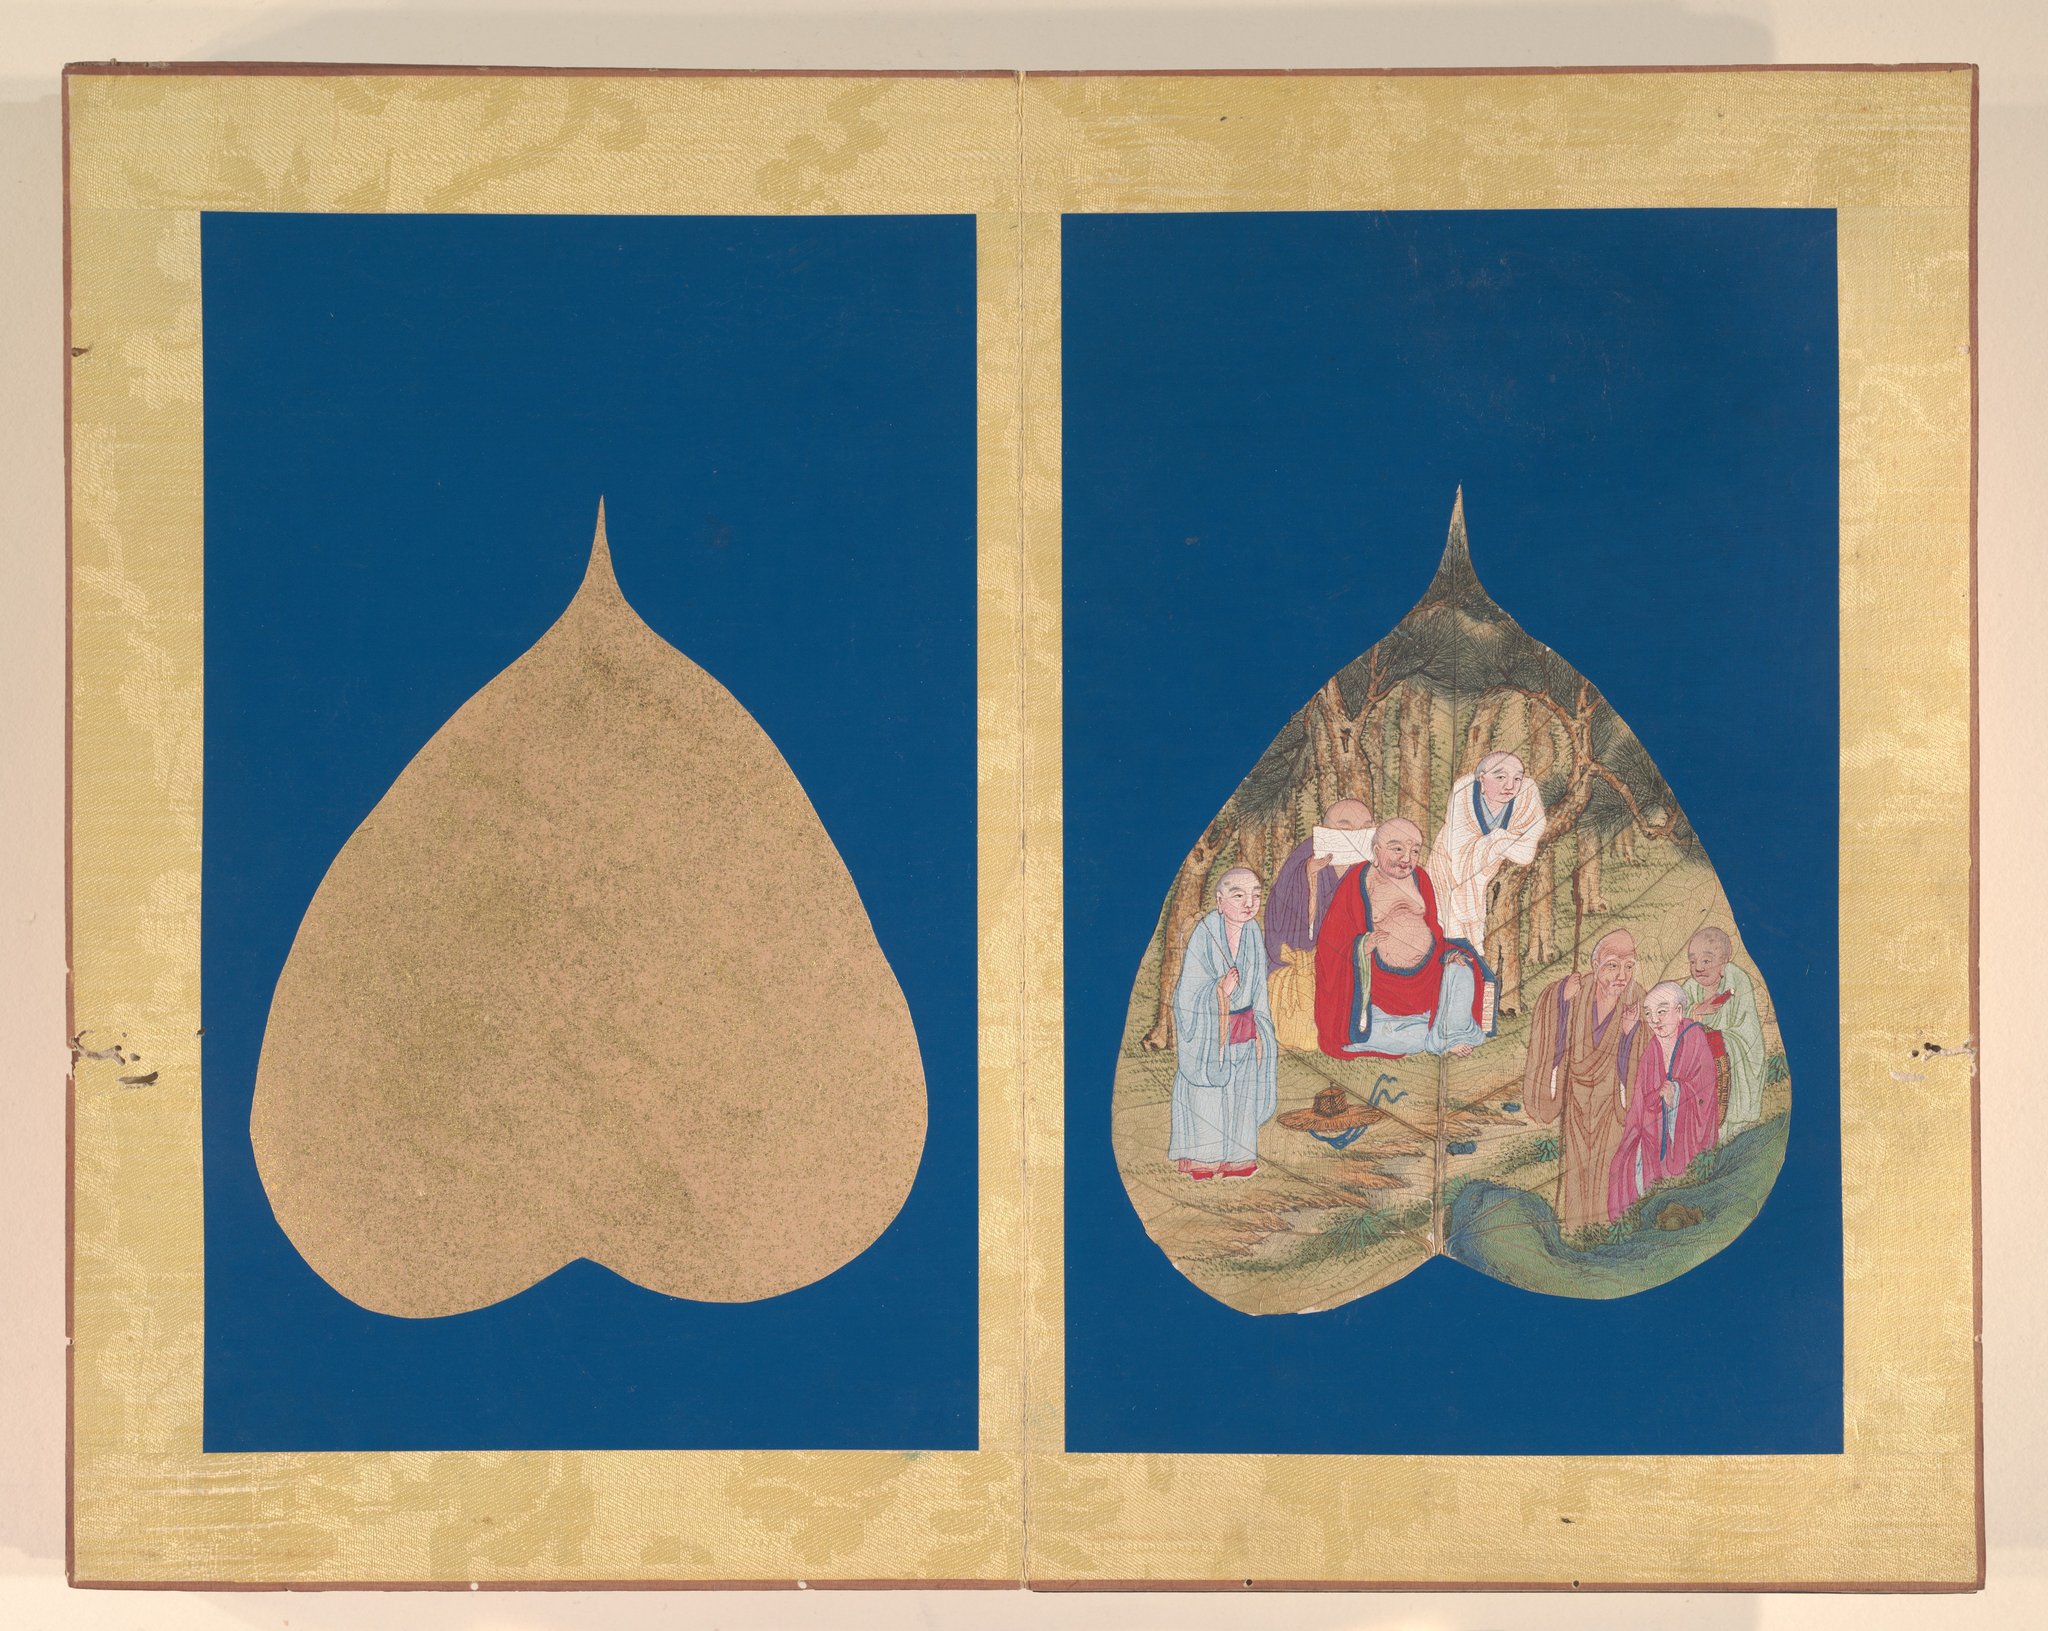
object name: album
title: Luohans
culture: chinese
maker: unidentified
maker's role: artist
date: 1601-1800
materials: ink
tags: men,buddhism